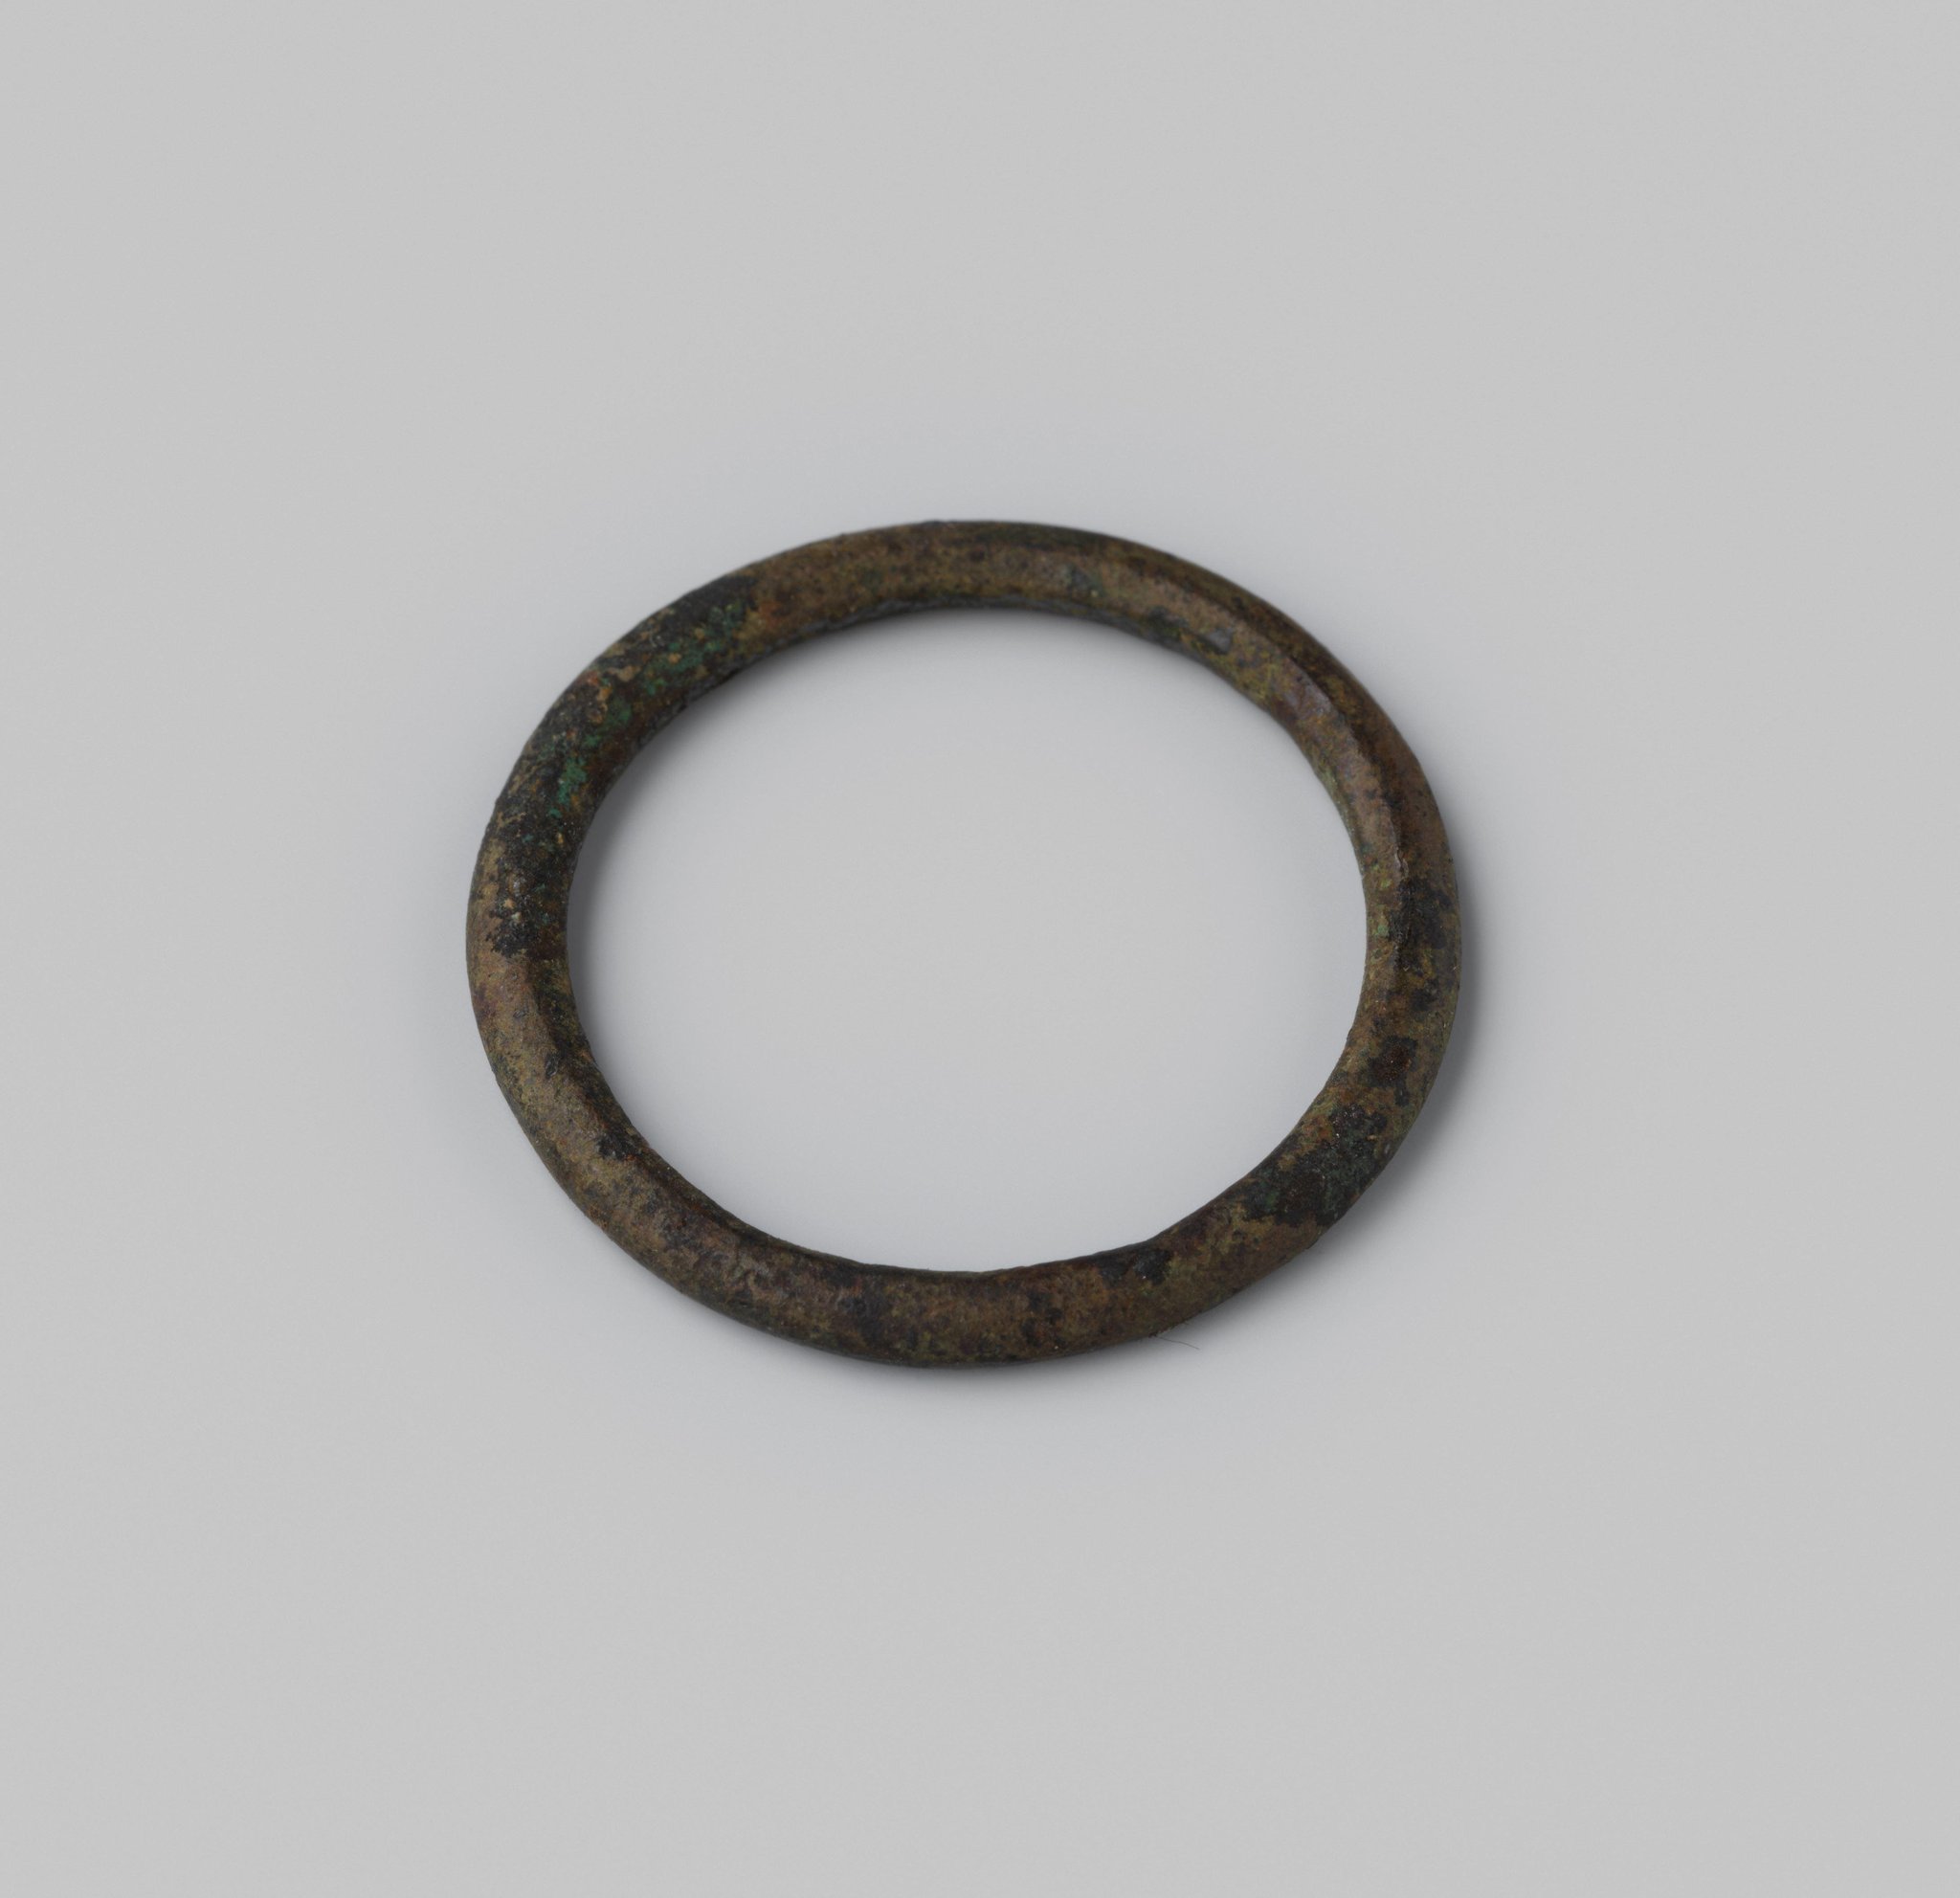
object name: ring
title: Ringvormig fragment uit het wrak van de Oost-Indiëvaarder Hollandia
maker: Anonymous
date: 1700-1743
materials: copper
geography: netherlands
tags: verenigde oostindische compagnie, hollandia (schip), annet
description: Varied parts or fragments, rings or ring-shaped fragments; circular, circular in section.